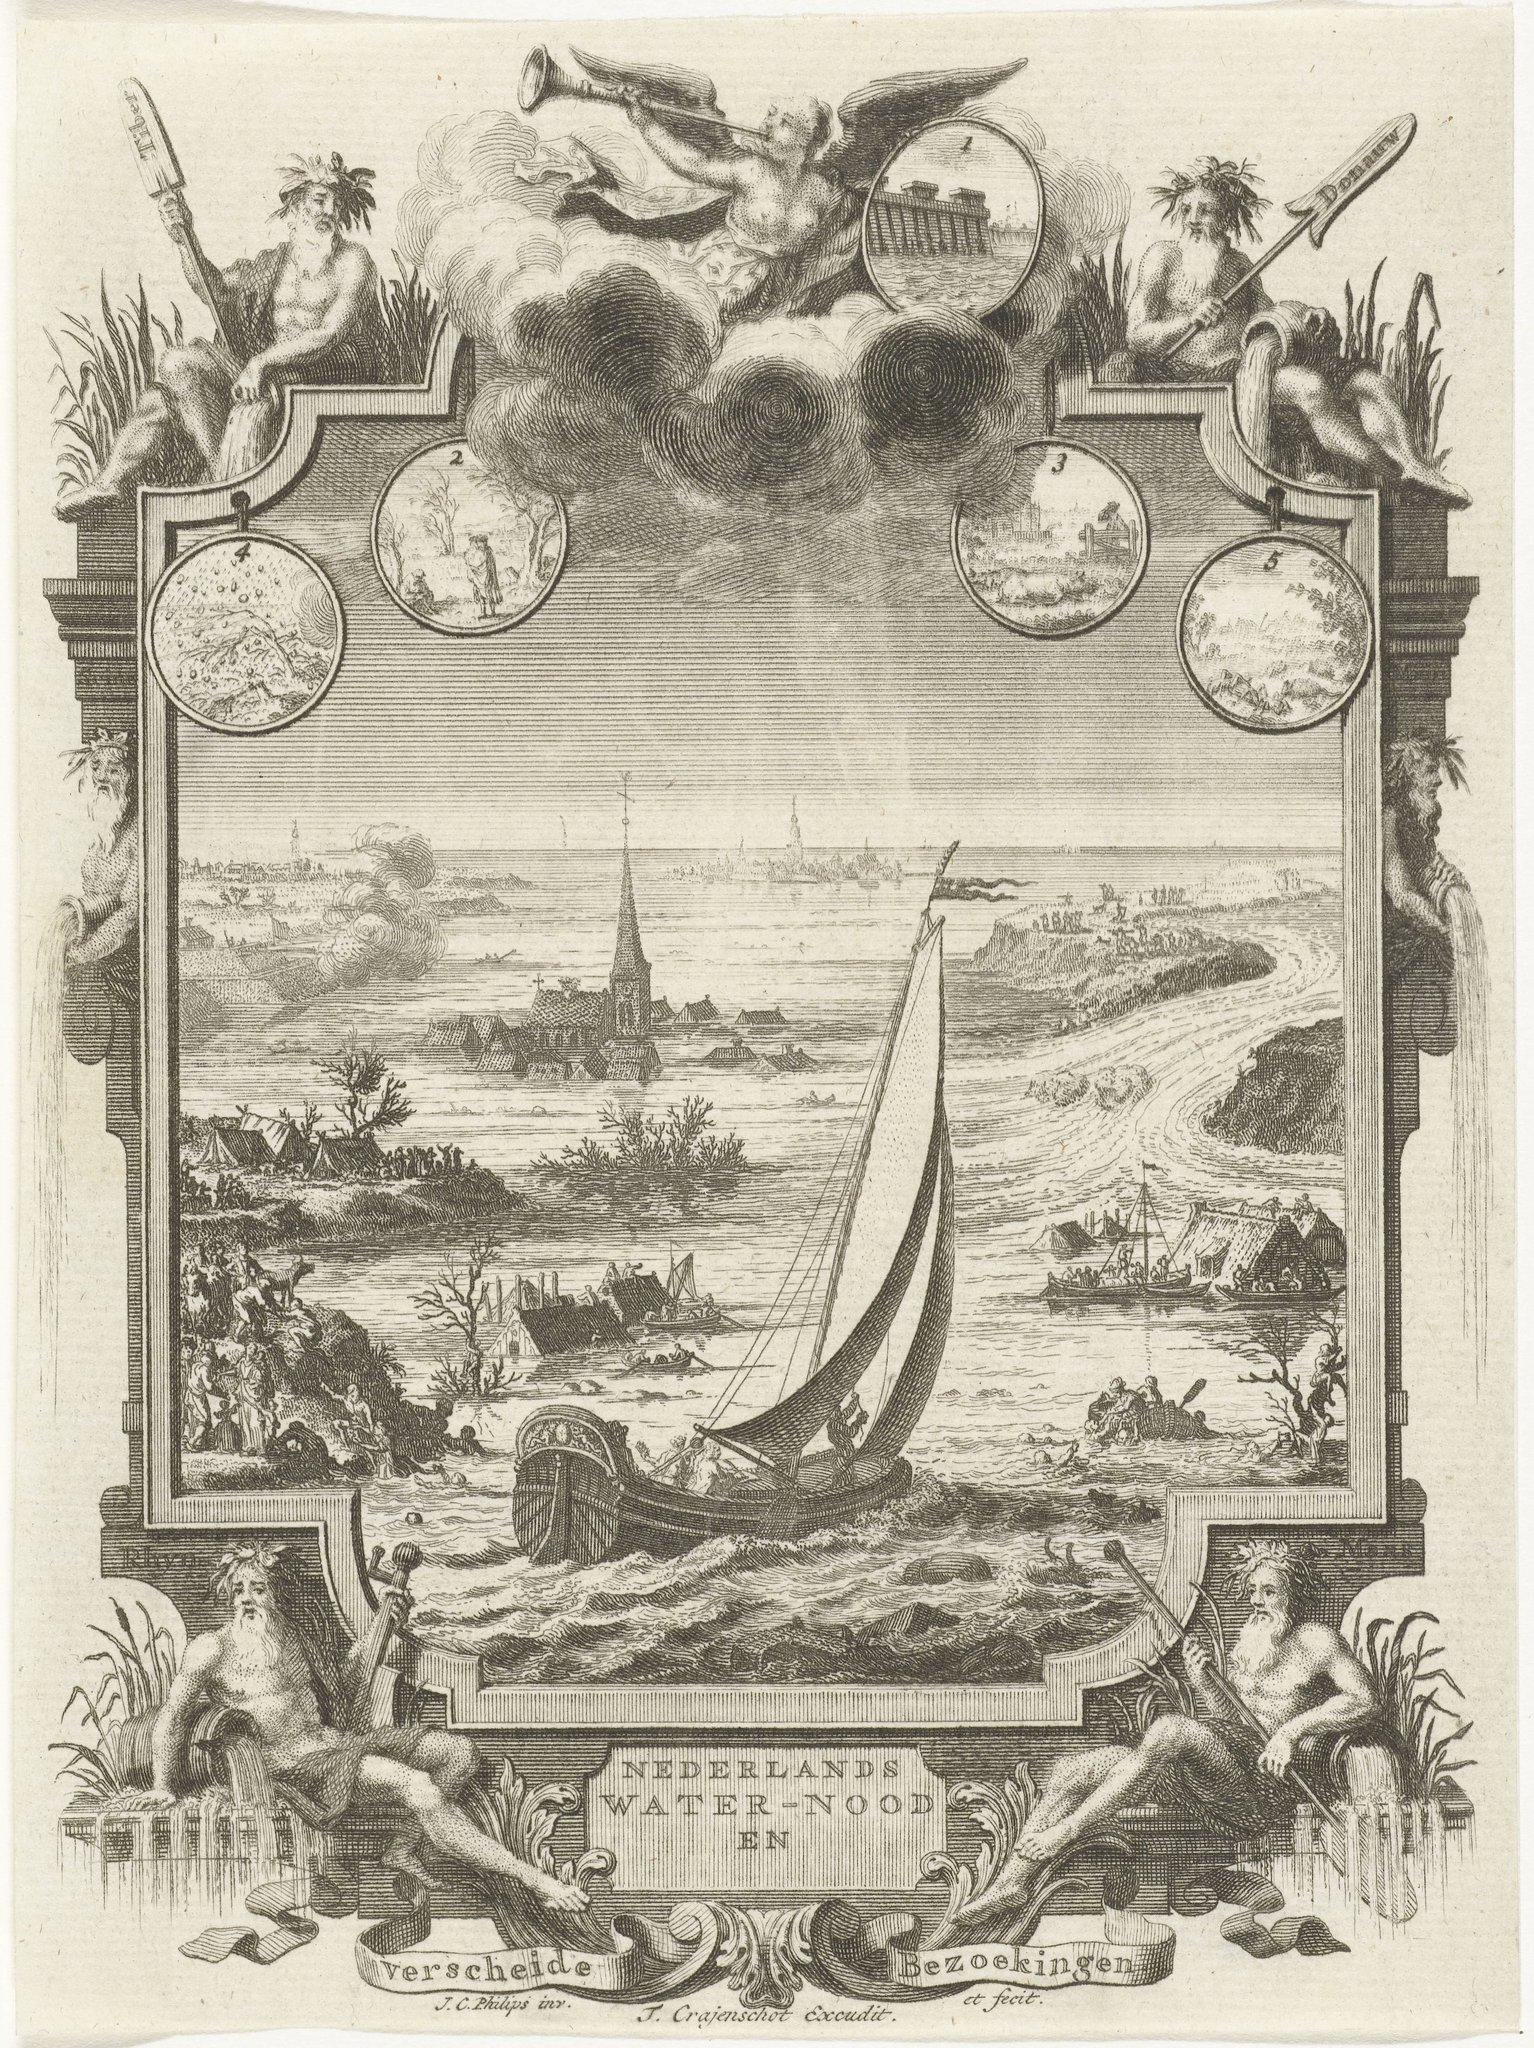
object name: print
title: Nederlands Water-Nood en verscheide bezoekingen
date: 1741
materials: paper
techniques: engraving, etching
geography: northern netherlands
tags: dike-break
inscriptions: collector's mark: Lugt 2228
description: Allegorische plaat over Nederland getroffen door de watersnood van 14-18 november 1775 en andere rampen in dit jaar en in 1776. Centraal een jacht die over het overstroomd land en langs verdronken dorpen zeilt tijdens de watersnood. Bovenaan vijf medaillons met verwijzingen naar andere rampen als paalworm, strenge winter etc. In allegorische omlijsting met de Faam en vier riviergoden.